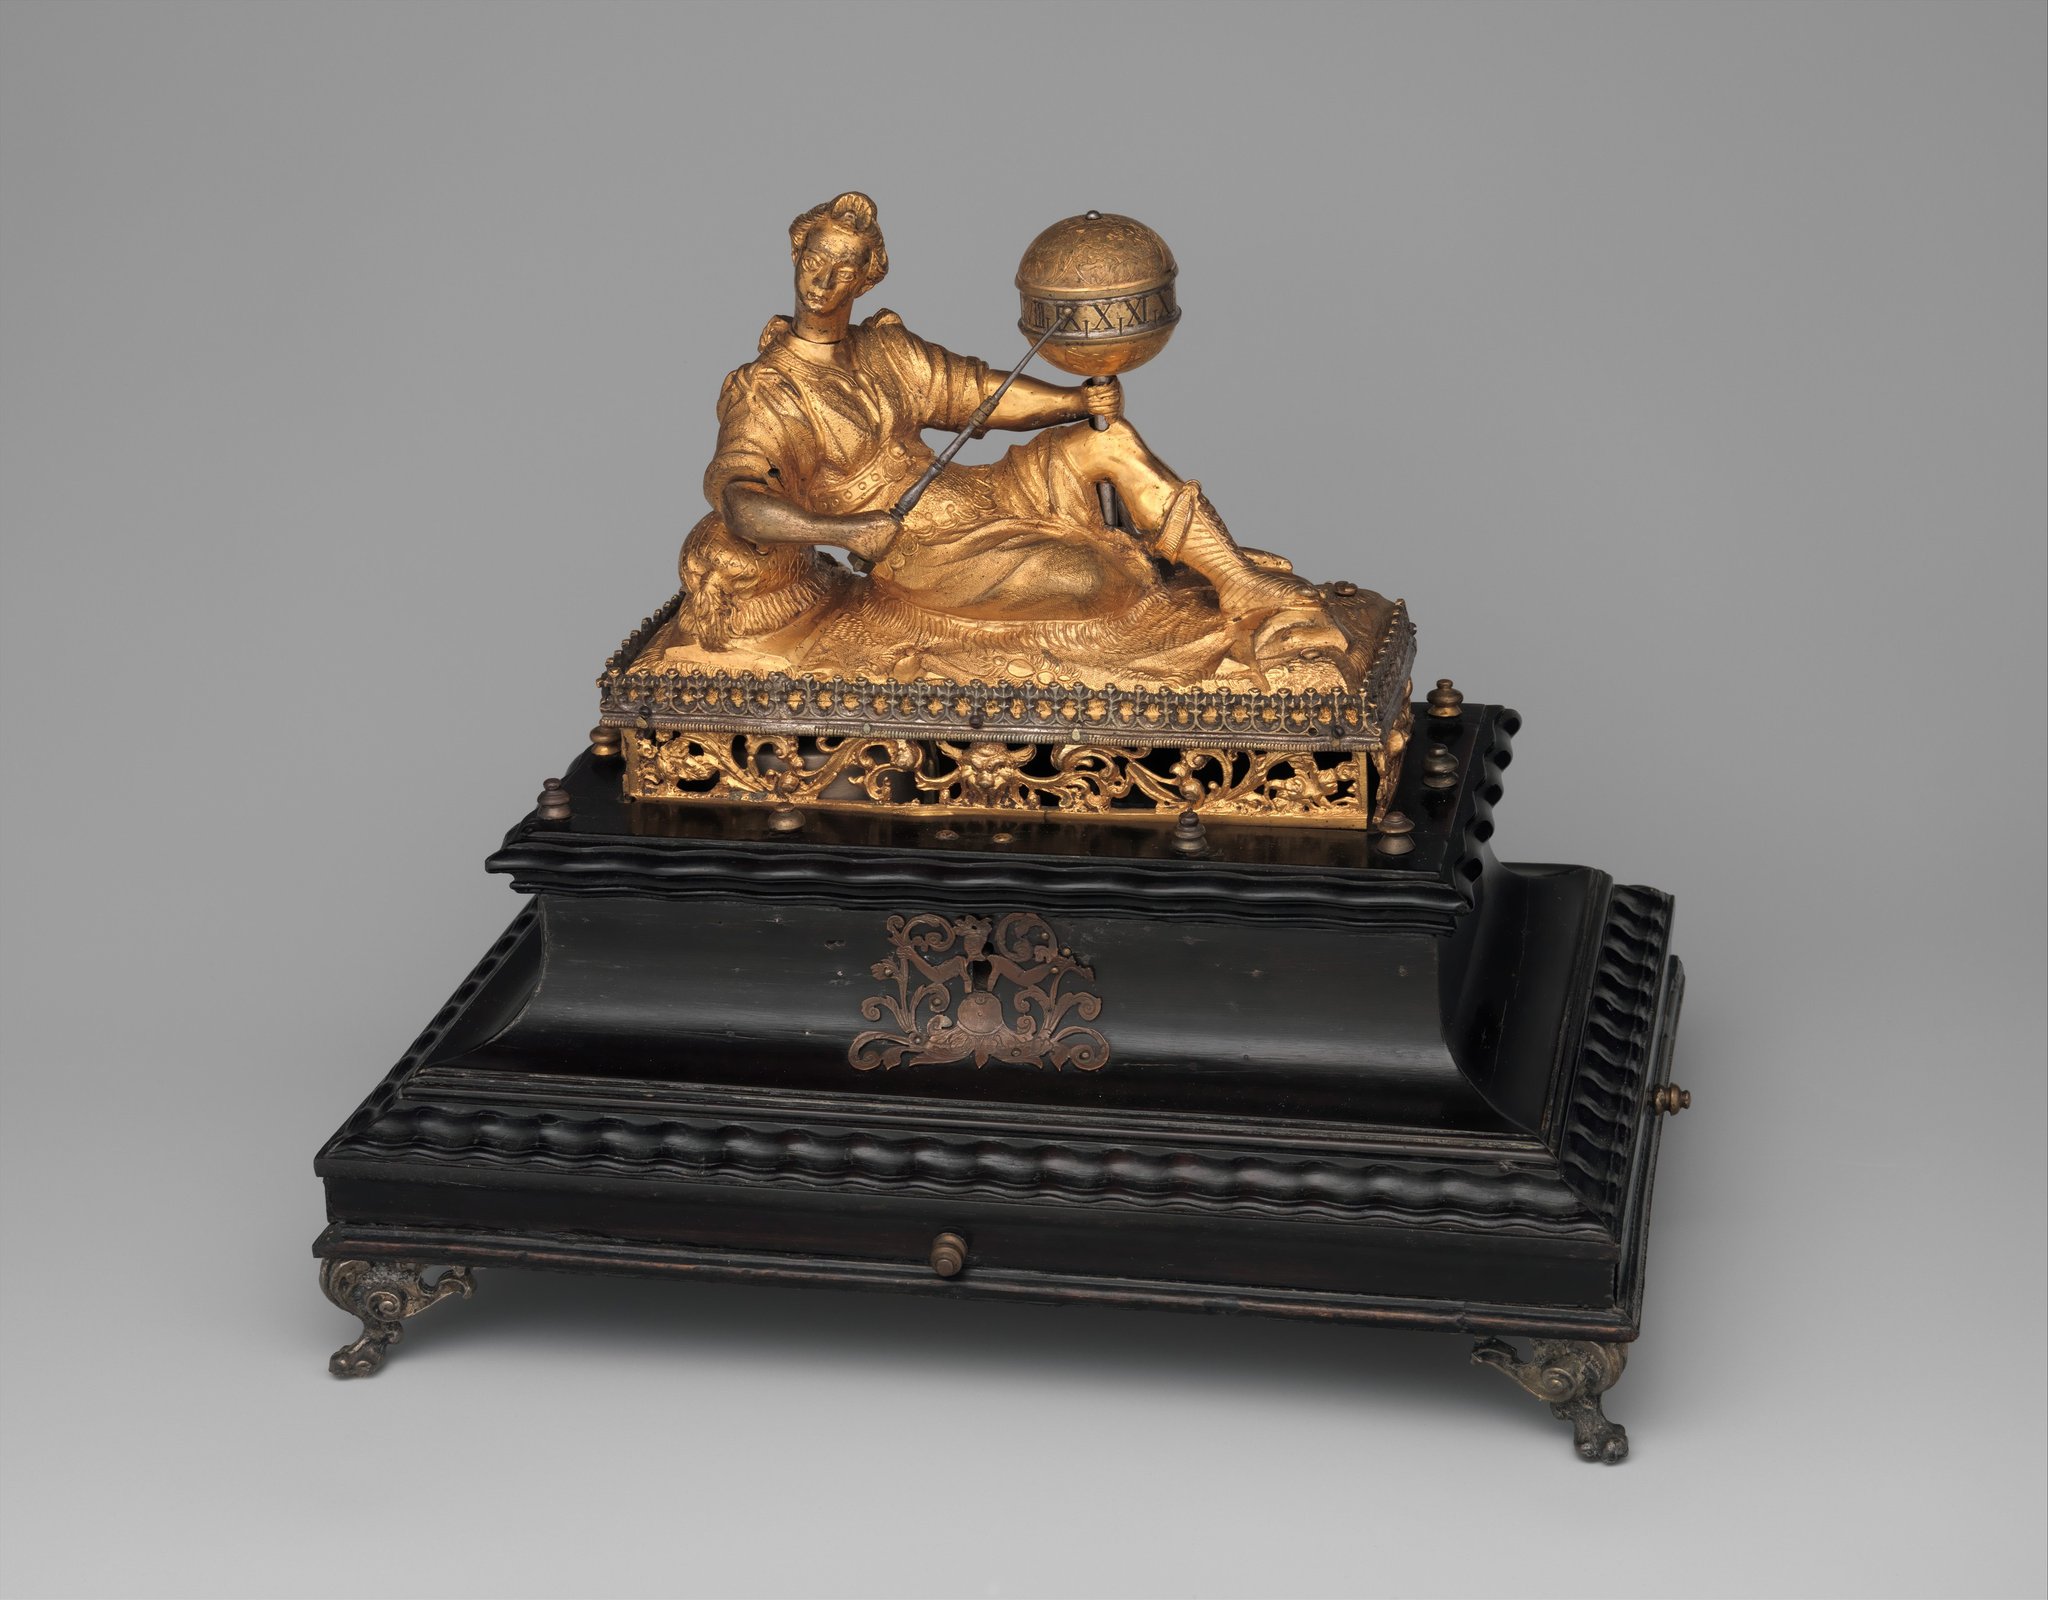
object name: automaton clock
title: Automaton clock in the form of Urania, Muse of Astronomy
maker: paullus schiller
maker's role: maker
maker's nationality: german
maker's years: 1583-1634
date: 1620-1630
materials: brass, copper, wood, gilt brass, silver, steel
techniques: gilding, silvered, veneering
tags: astronomy